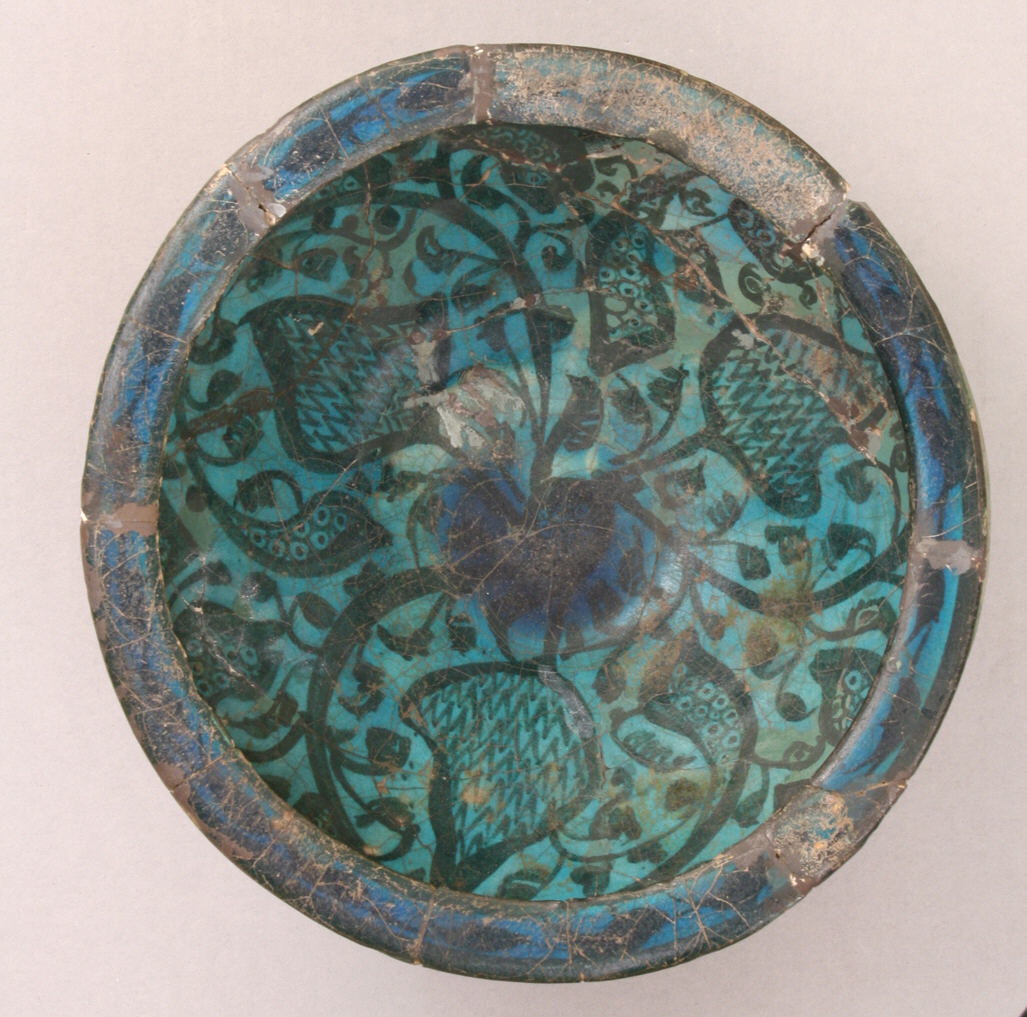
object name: bowl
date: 1201-1400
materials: stonepaste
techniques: painting, underglaze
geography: iran